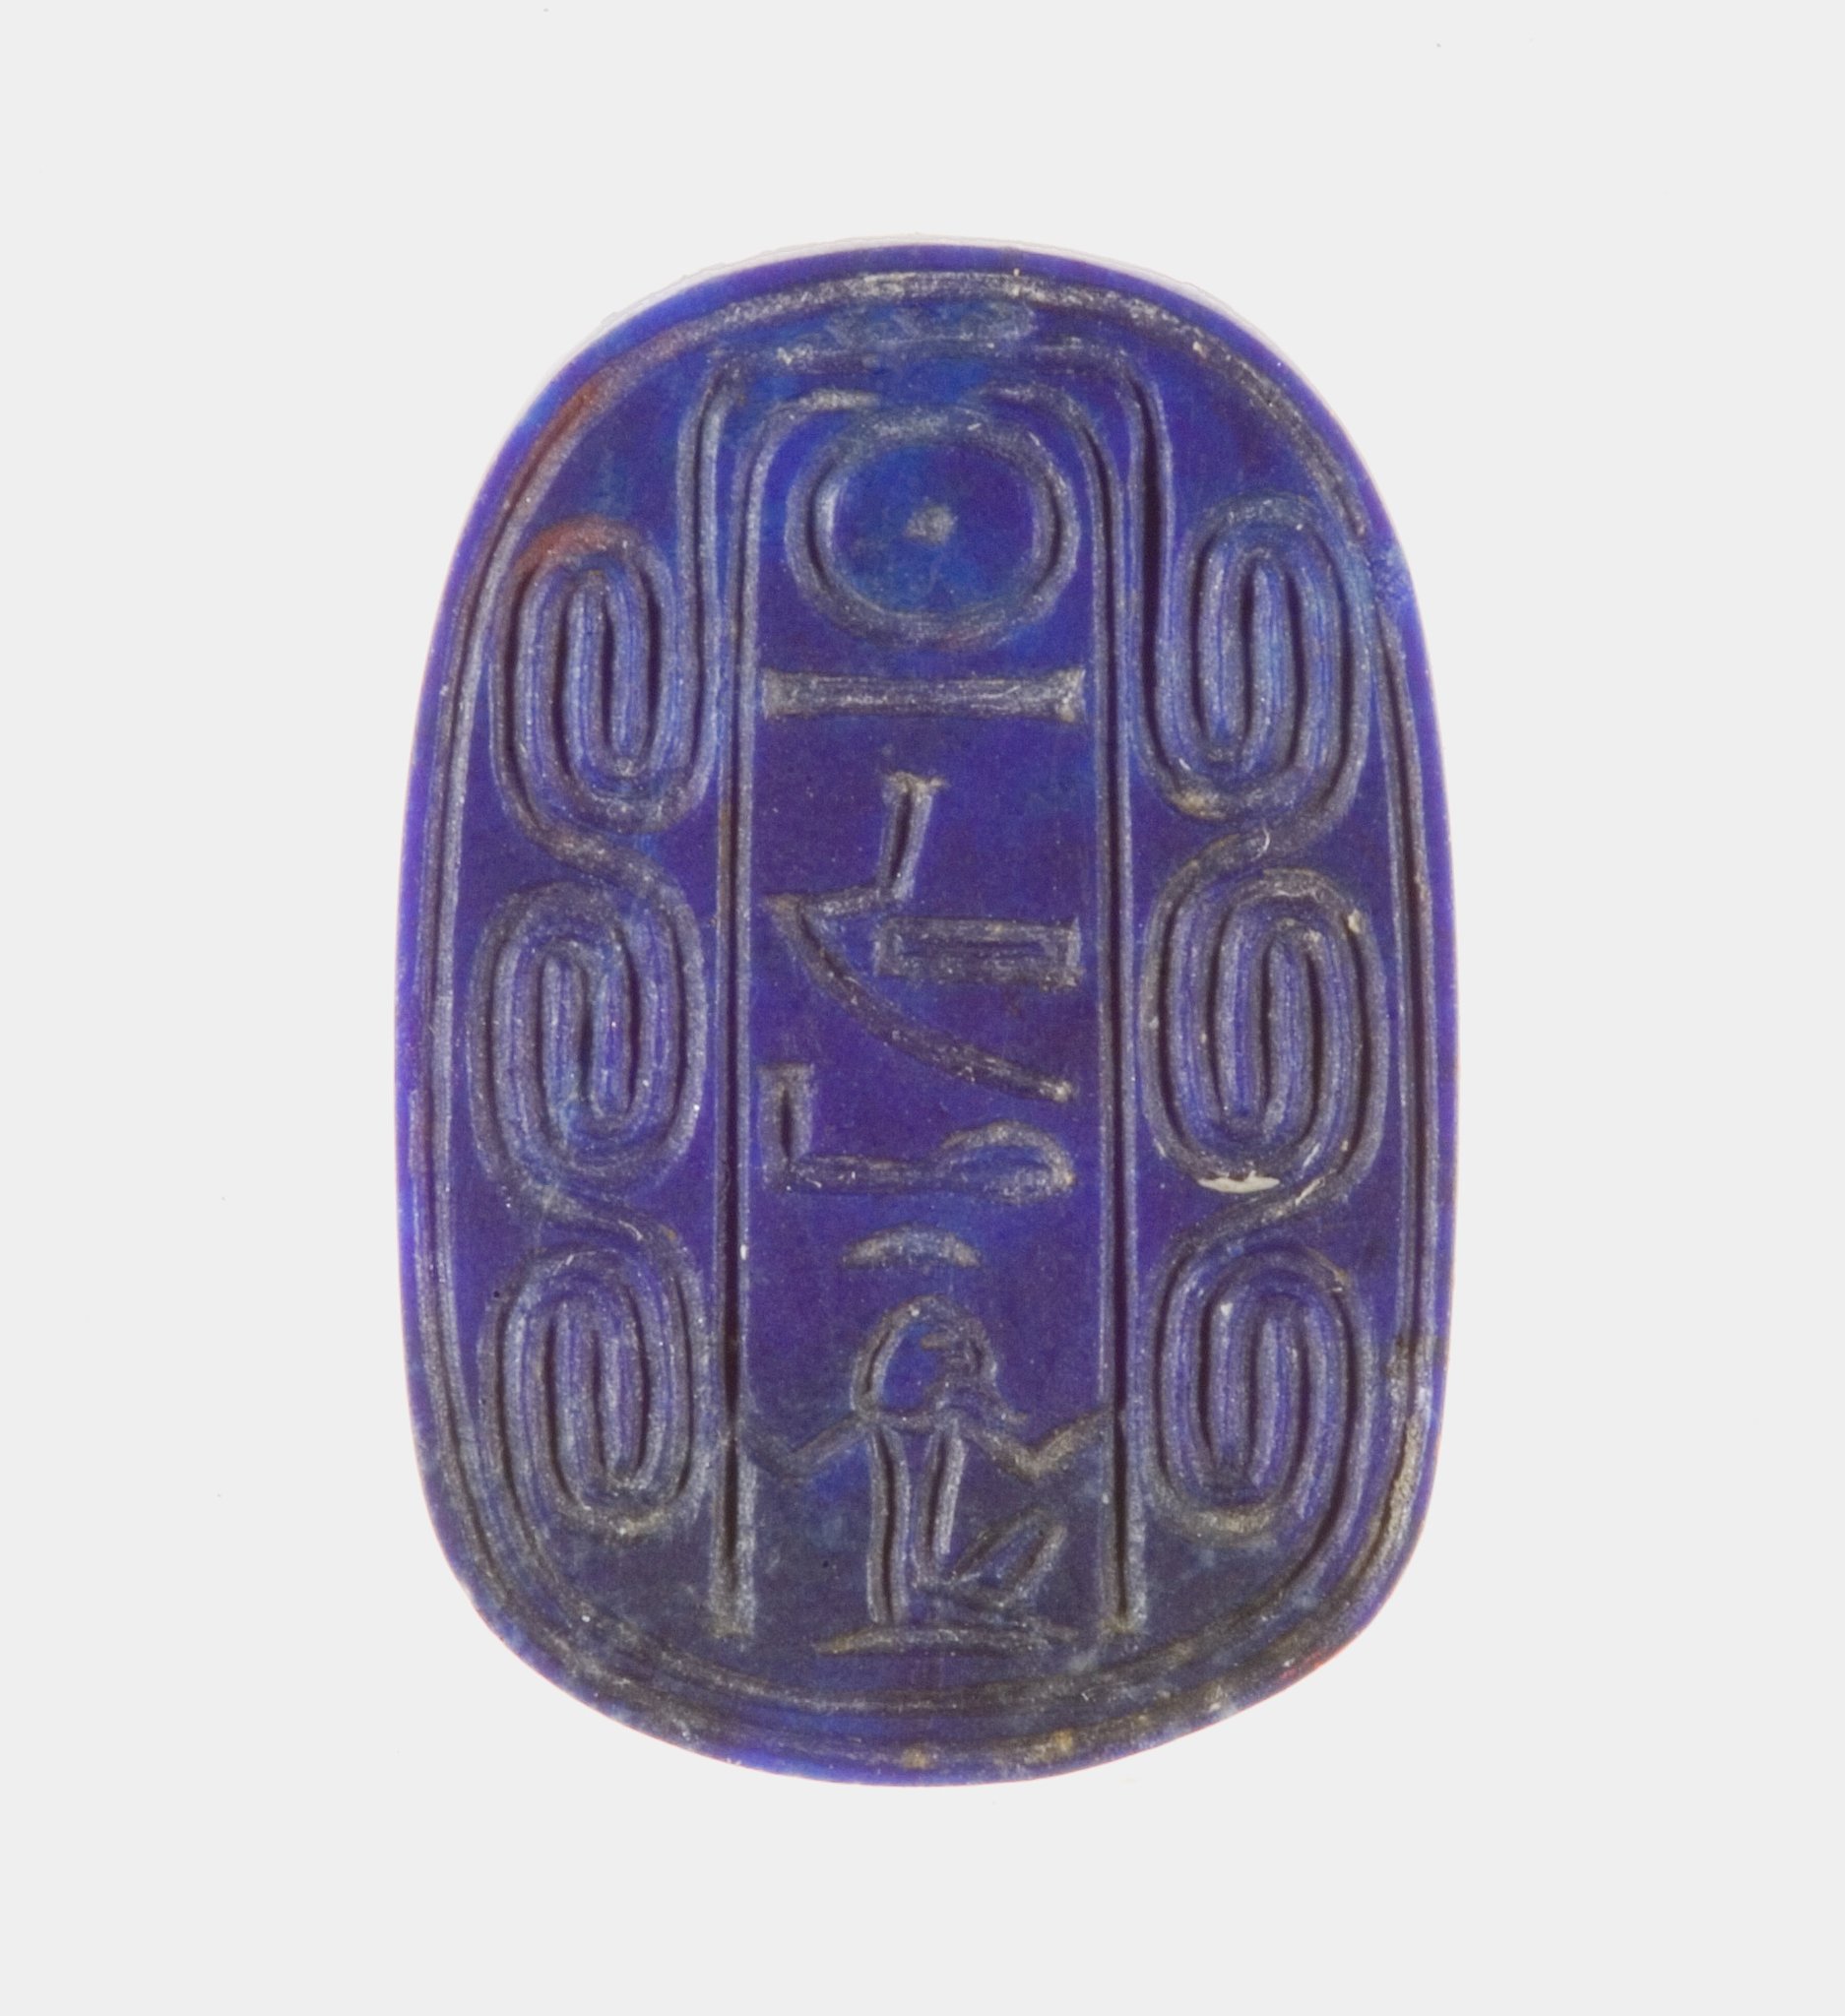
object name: scarab, sithathoryunet, amenemhat iii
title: Scarab of Sithathoryunet with the Name of Amenemhat III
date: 1887-1813 BCE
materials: lapis lazuli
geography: egypt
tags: hieroglyphs,scarabs